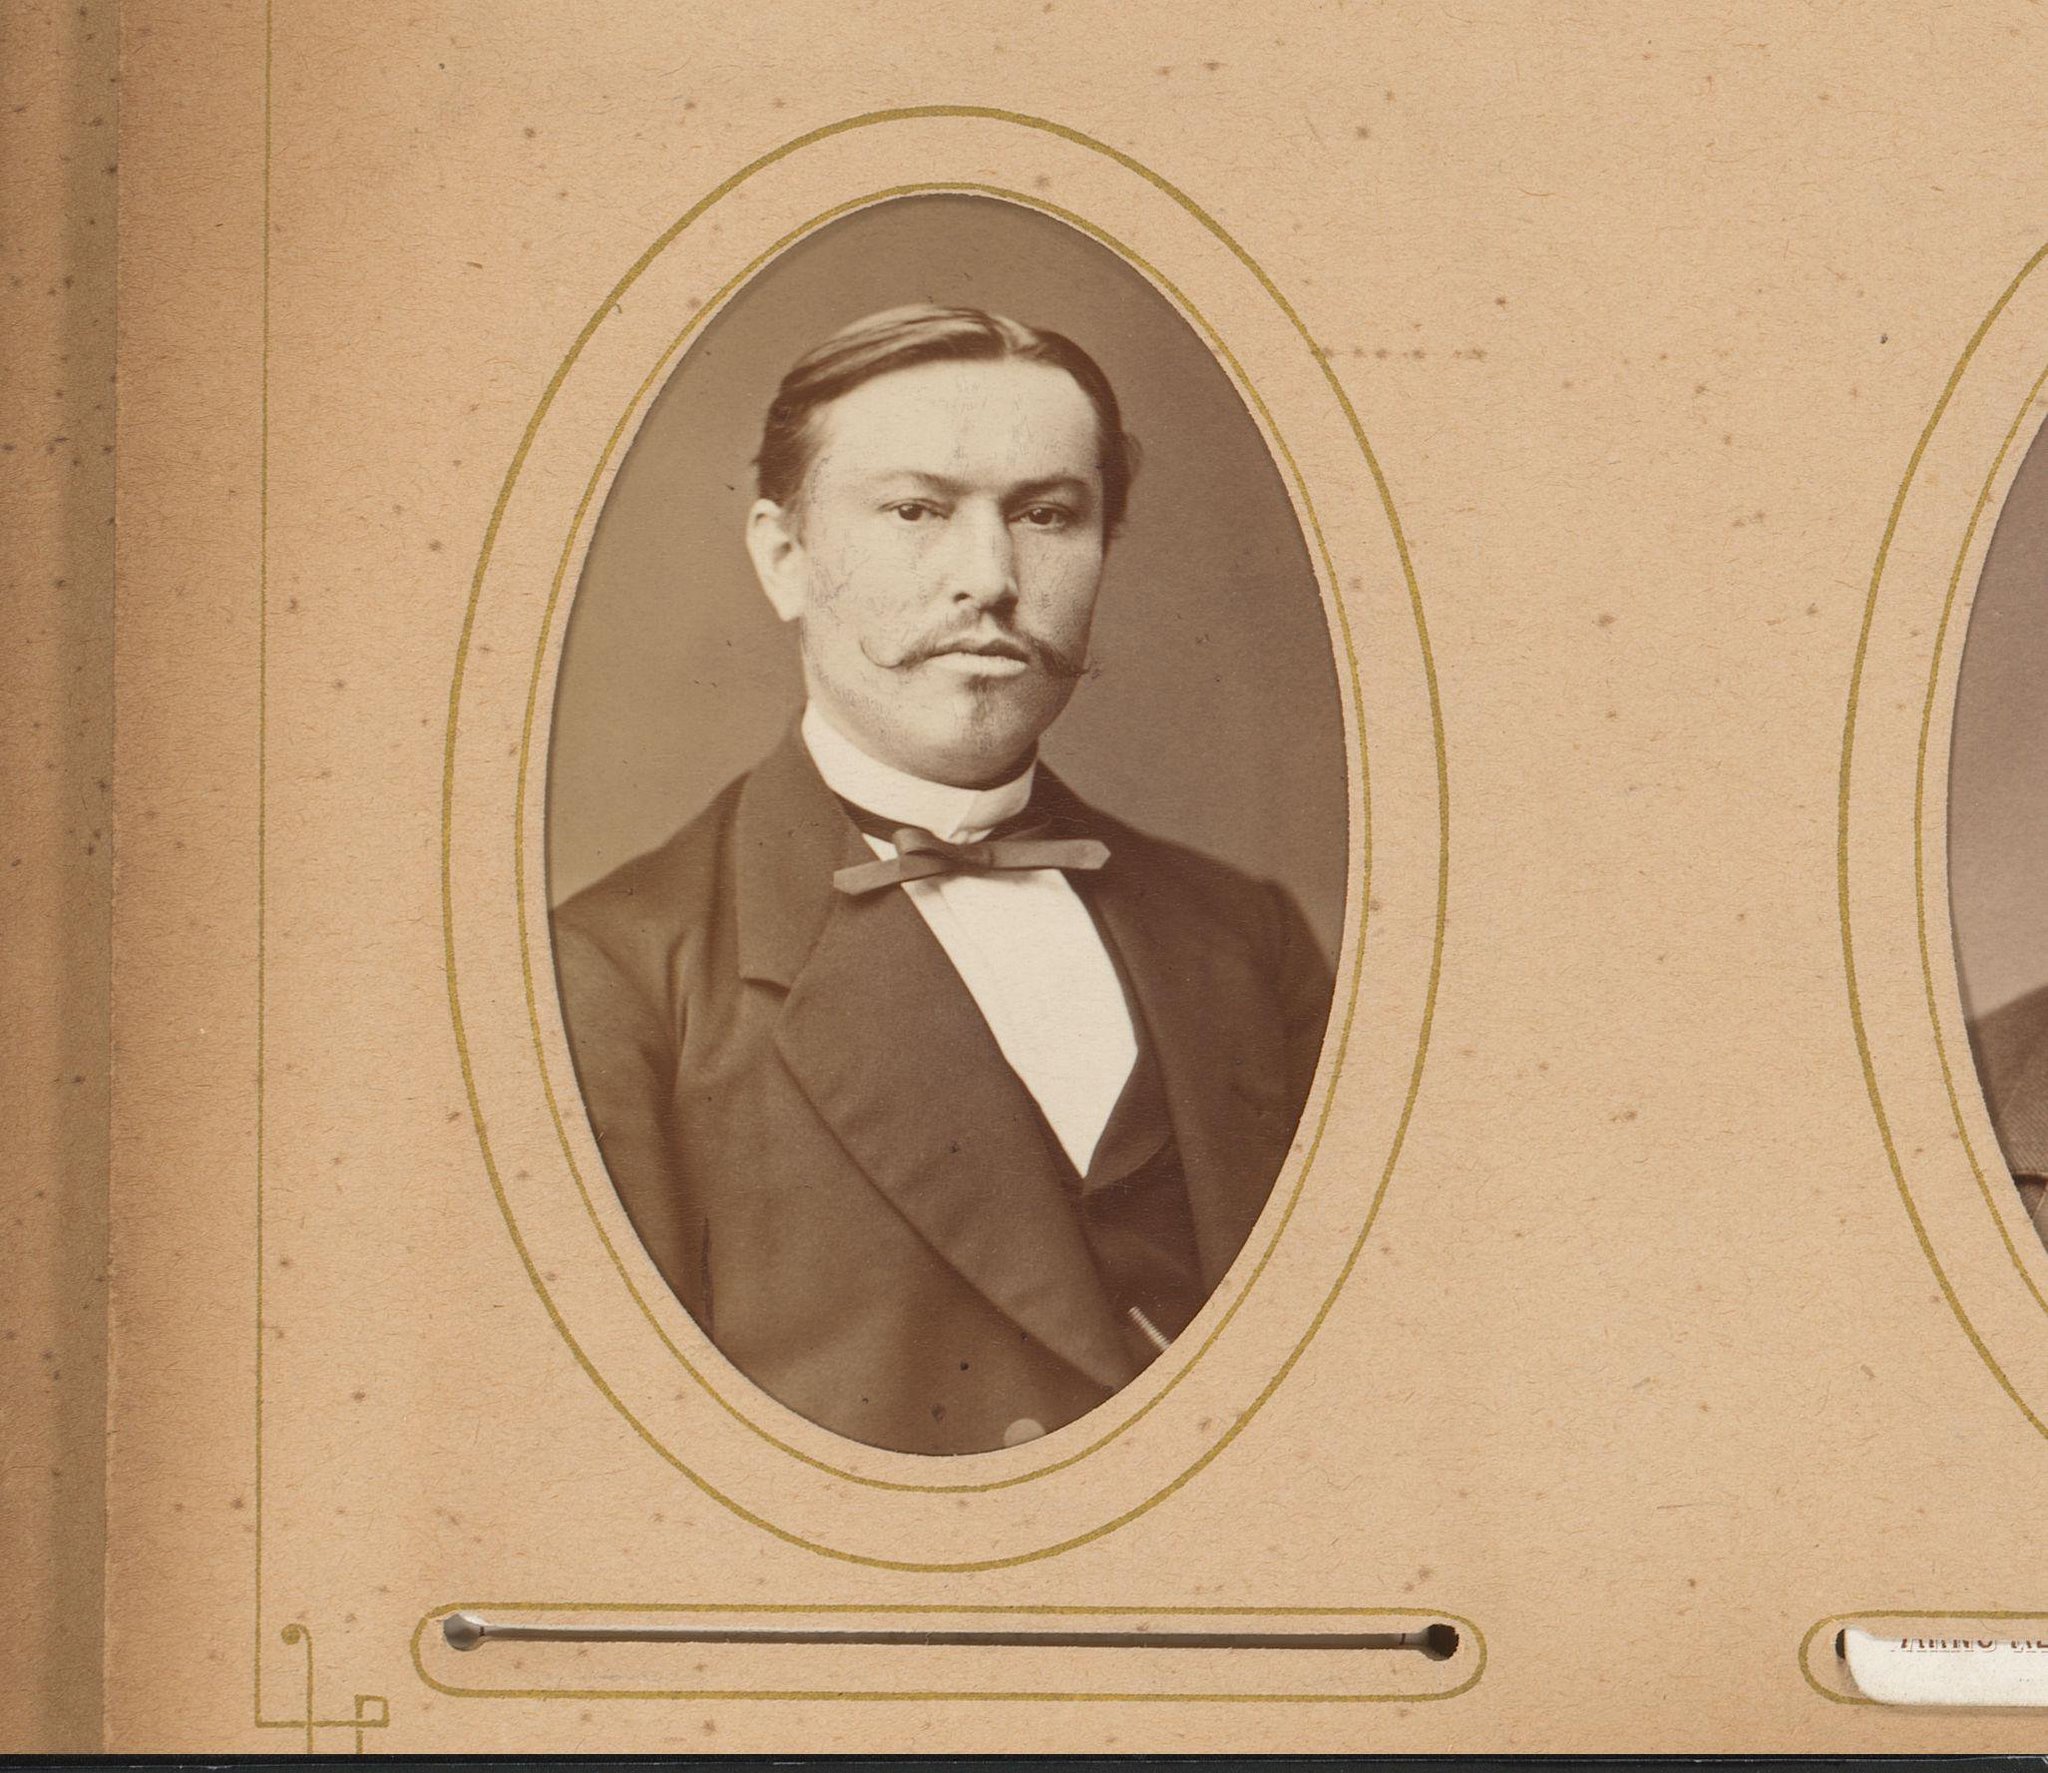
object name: photograph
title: Portret van een man met snor en vlinderstrik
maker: b. obrist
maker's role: fotograaf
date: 1860-1900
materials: cardboard, photographic support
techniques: albumen print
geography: frankenthal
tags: moustache, historical persons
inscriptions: inscription: ‘Photographie/ von/ B. Obrist/ vis-à-vis dem Bahnhofe/ FRANKENTHAL./ Von diesem Bilde kann stets nachbestellt werden.’